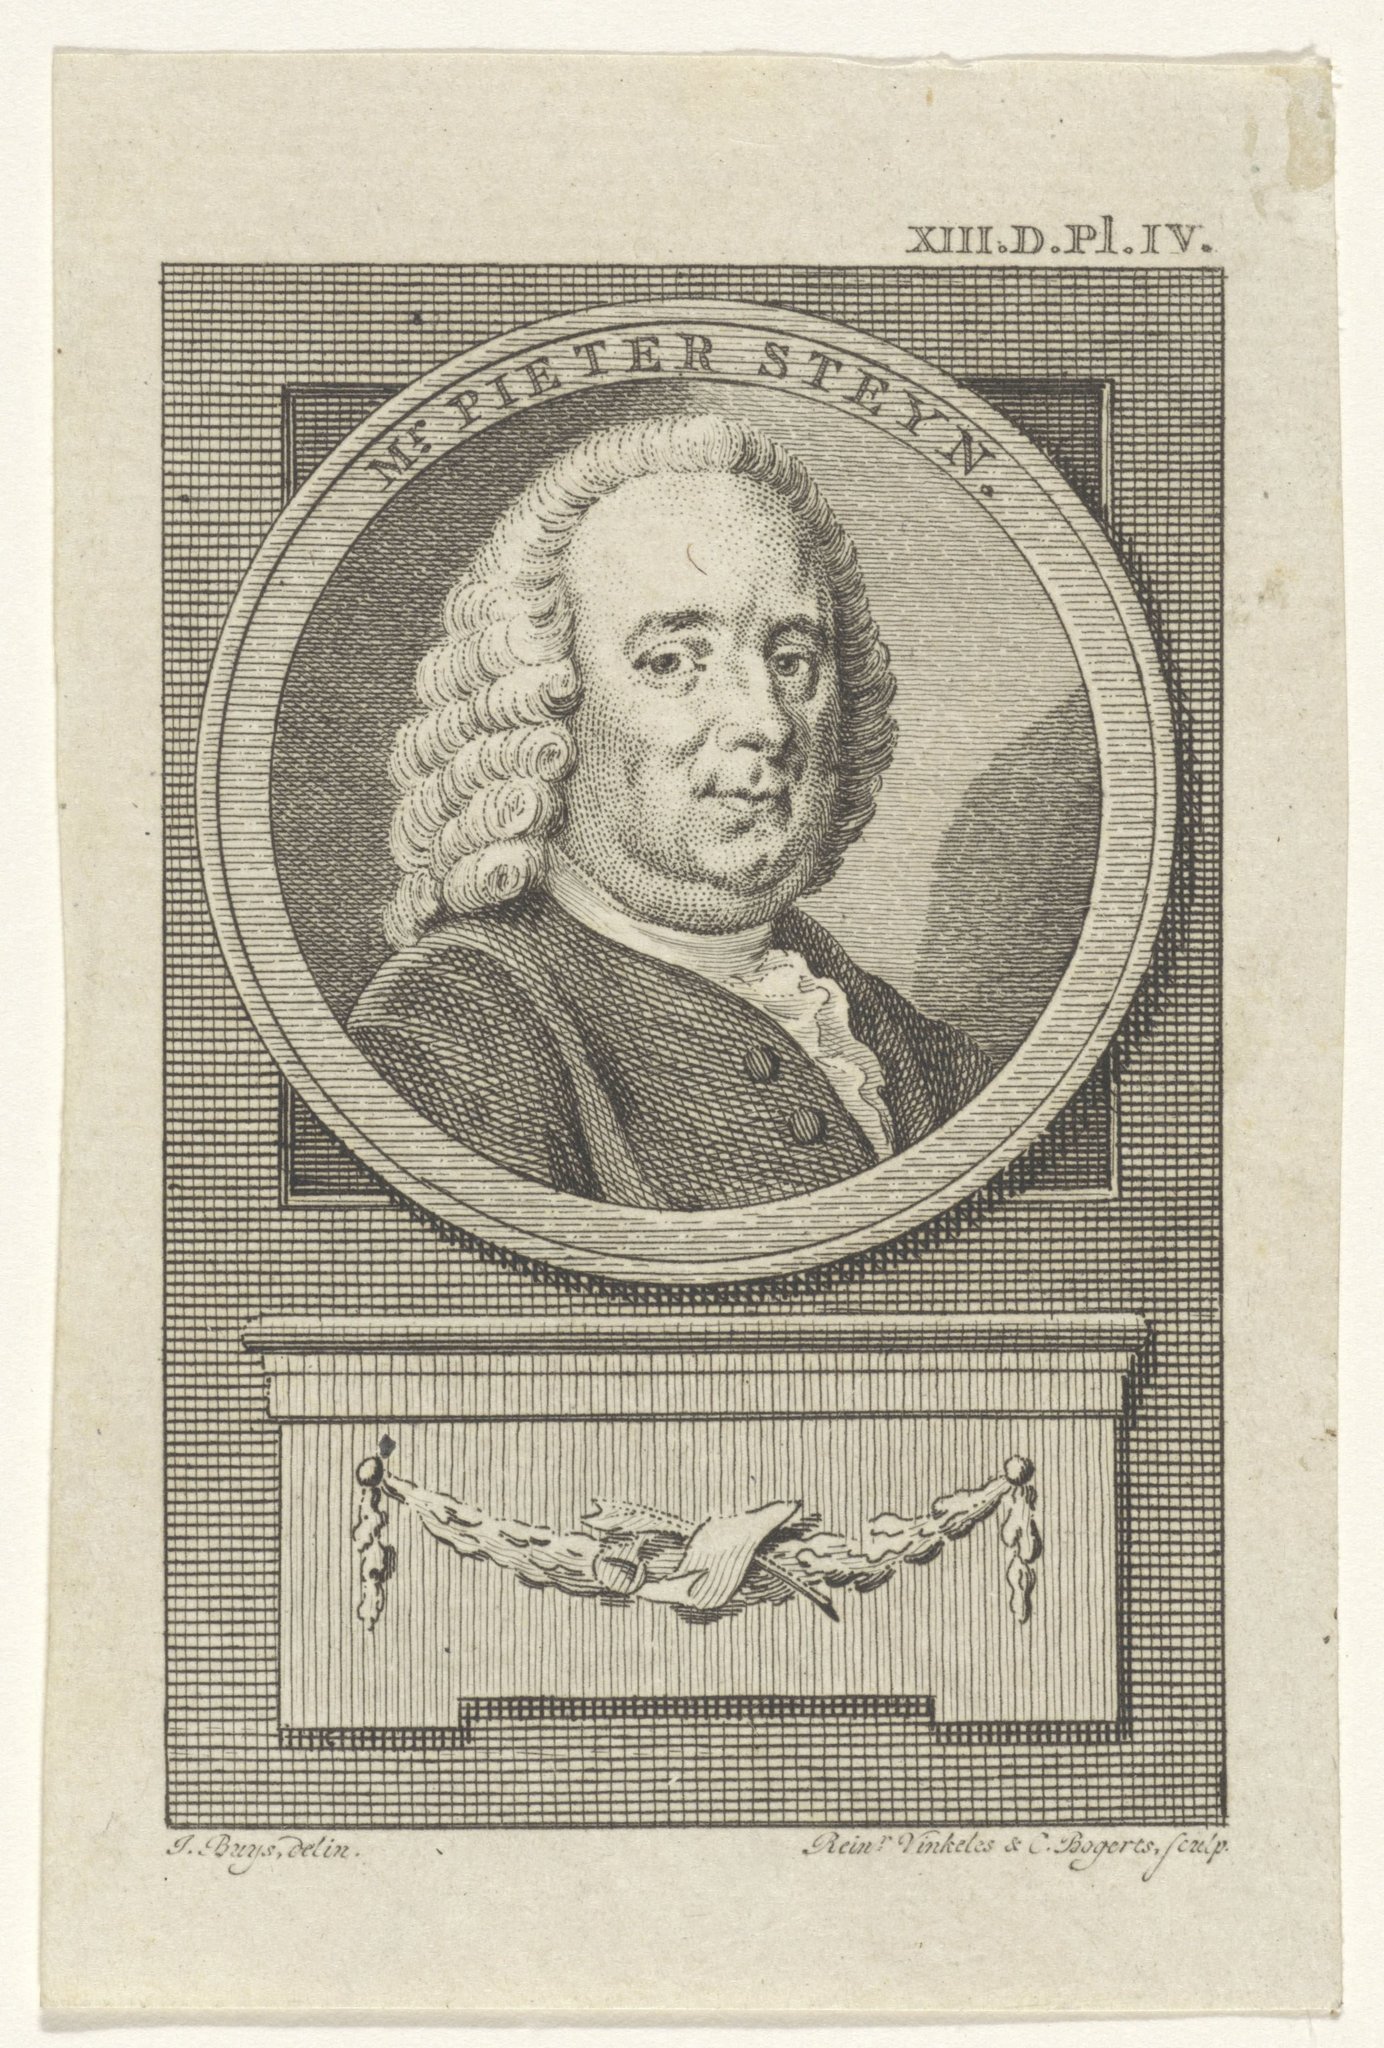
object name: print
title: Portret van Pieter Steijn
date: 1783-1795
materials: paper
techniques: engraving, etching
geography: amsterdam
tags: haarlem, the hague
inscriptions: collector's mark: Lugt 2228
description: Prent gebruikt in: Fokke, Jan. Geschiedenissen der Vereenigde Nederlanden voor de vaderlandsche jeugd Ie-XXVste deel. Amsterdam: Johannes Allart, 1783-1795. Deel XIII.